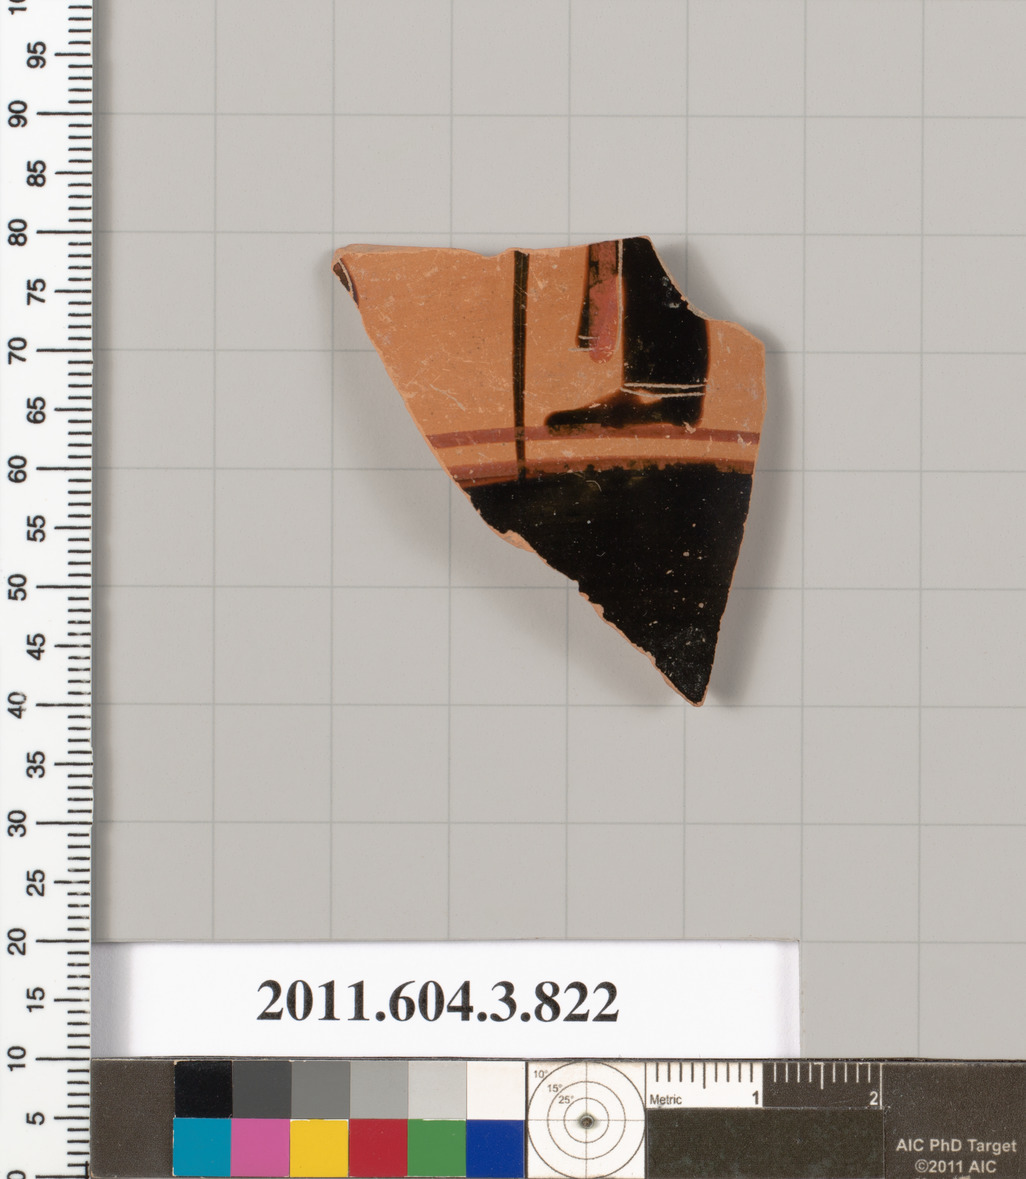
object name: lekythos fragment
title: Terracotta fragment of a lekythos (oil flask)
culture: greek, attic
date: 550-526 BCE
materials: terracotta